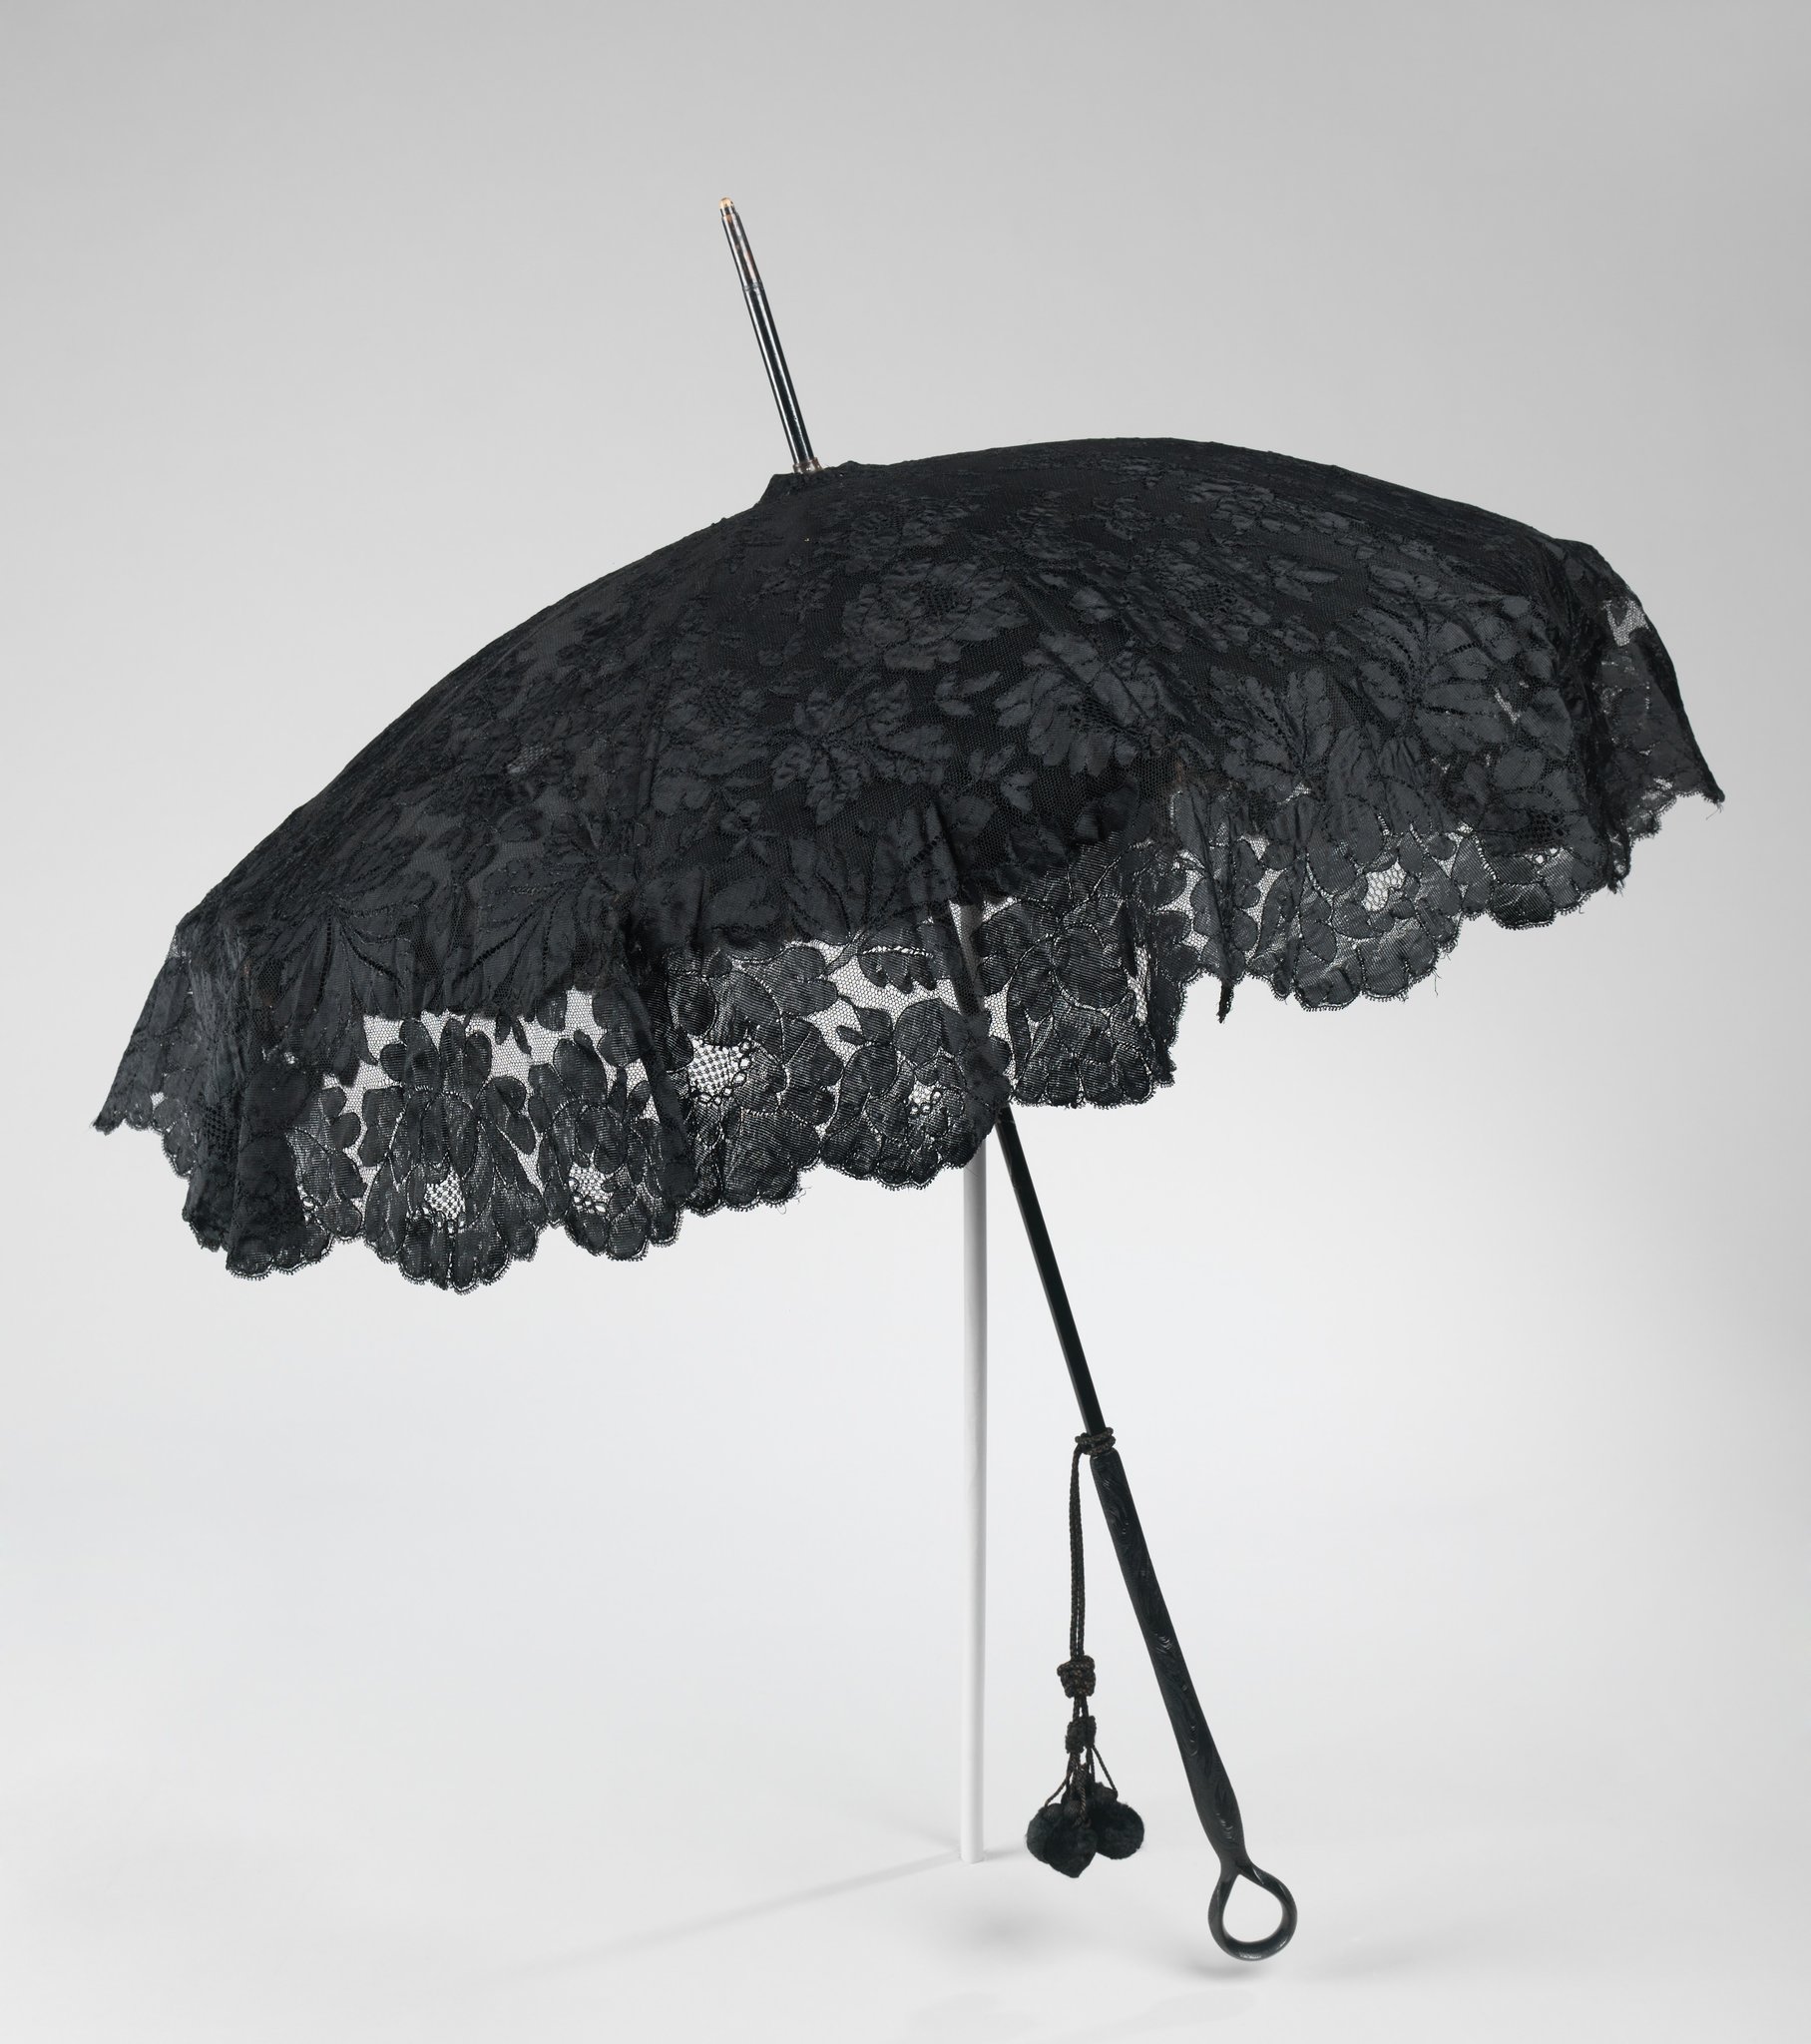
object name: parasol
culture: european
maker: g. fox & company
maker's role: manufacturer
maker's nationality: american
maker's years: 1847-1993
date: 1885-1890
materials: metal, silk, wood